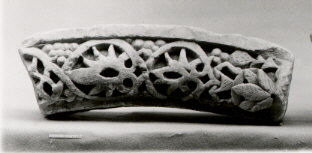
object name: fragment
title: Fragment of Archivolt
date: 501-700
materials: limestone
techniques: carving, relief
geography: egypt